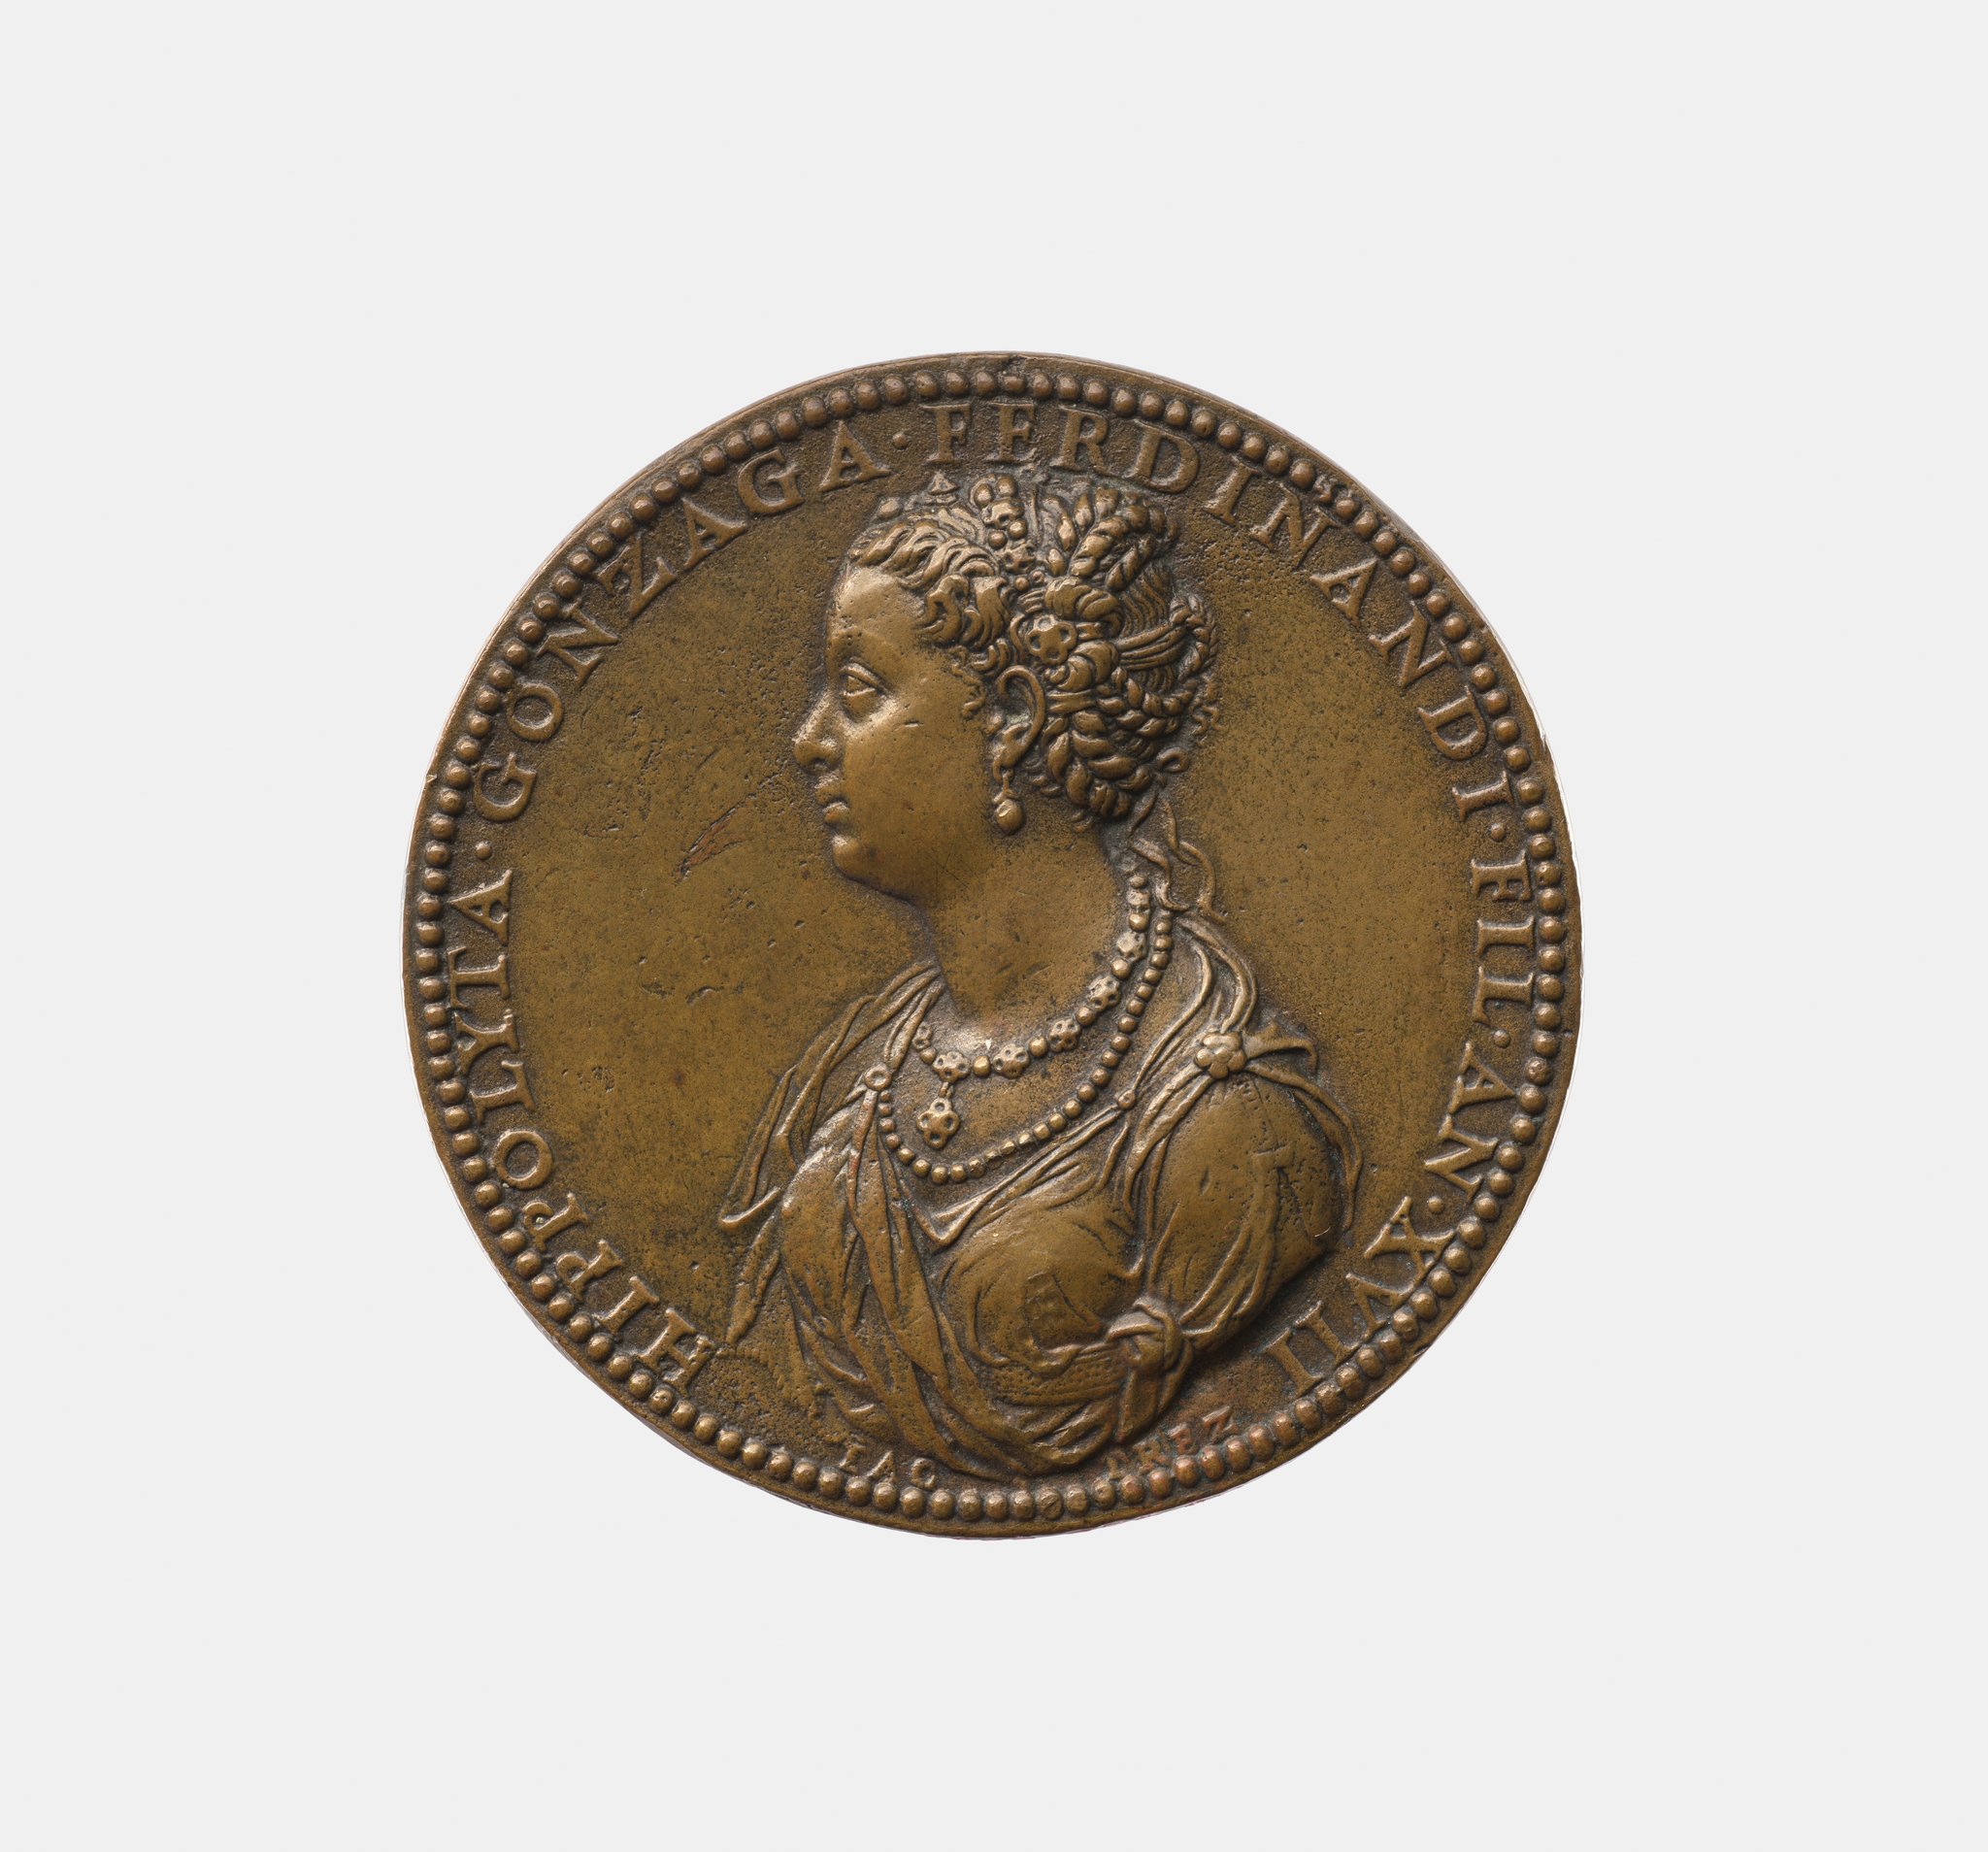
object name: medal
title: Ippolita Gonzaga 1535-63, wife of Antonio Caraffa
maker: jacopo nizolla da trezzo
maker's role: artist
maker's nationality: italian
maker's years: 1515-1589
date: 1552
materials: bronze